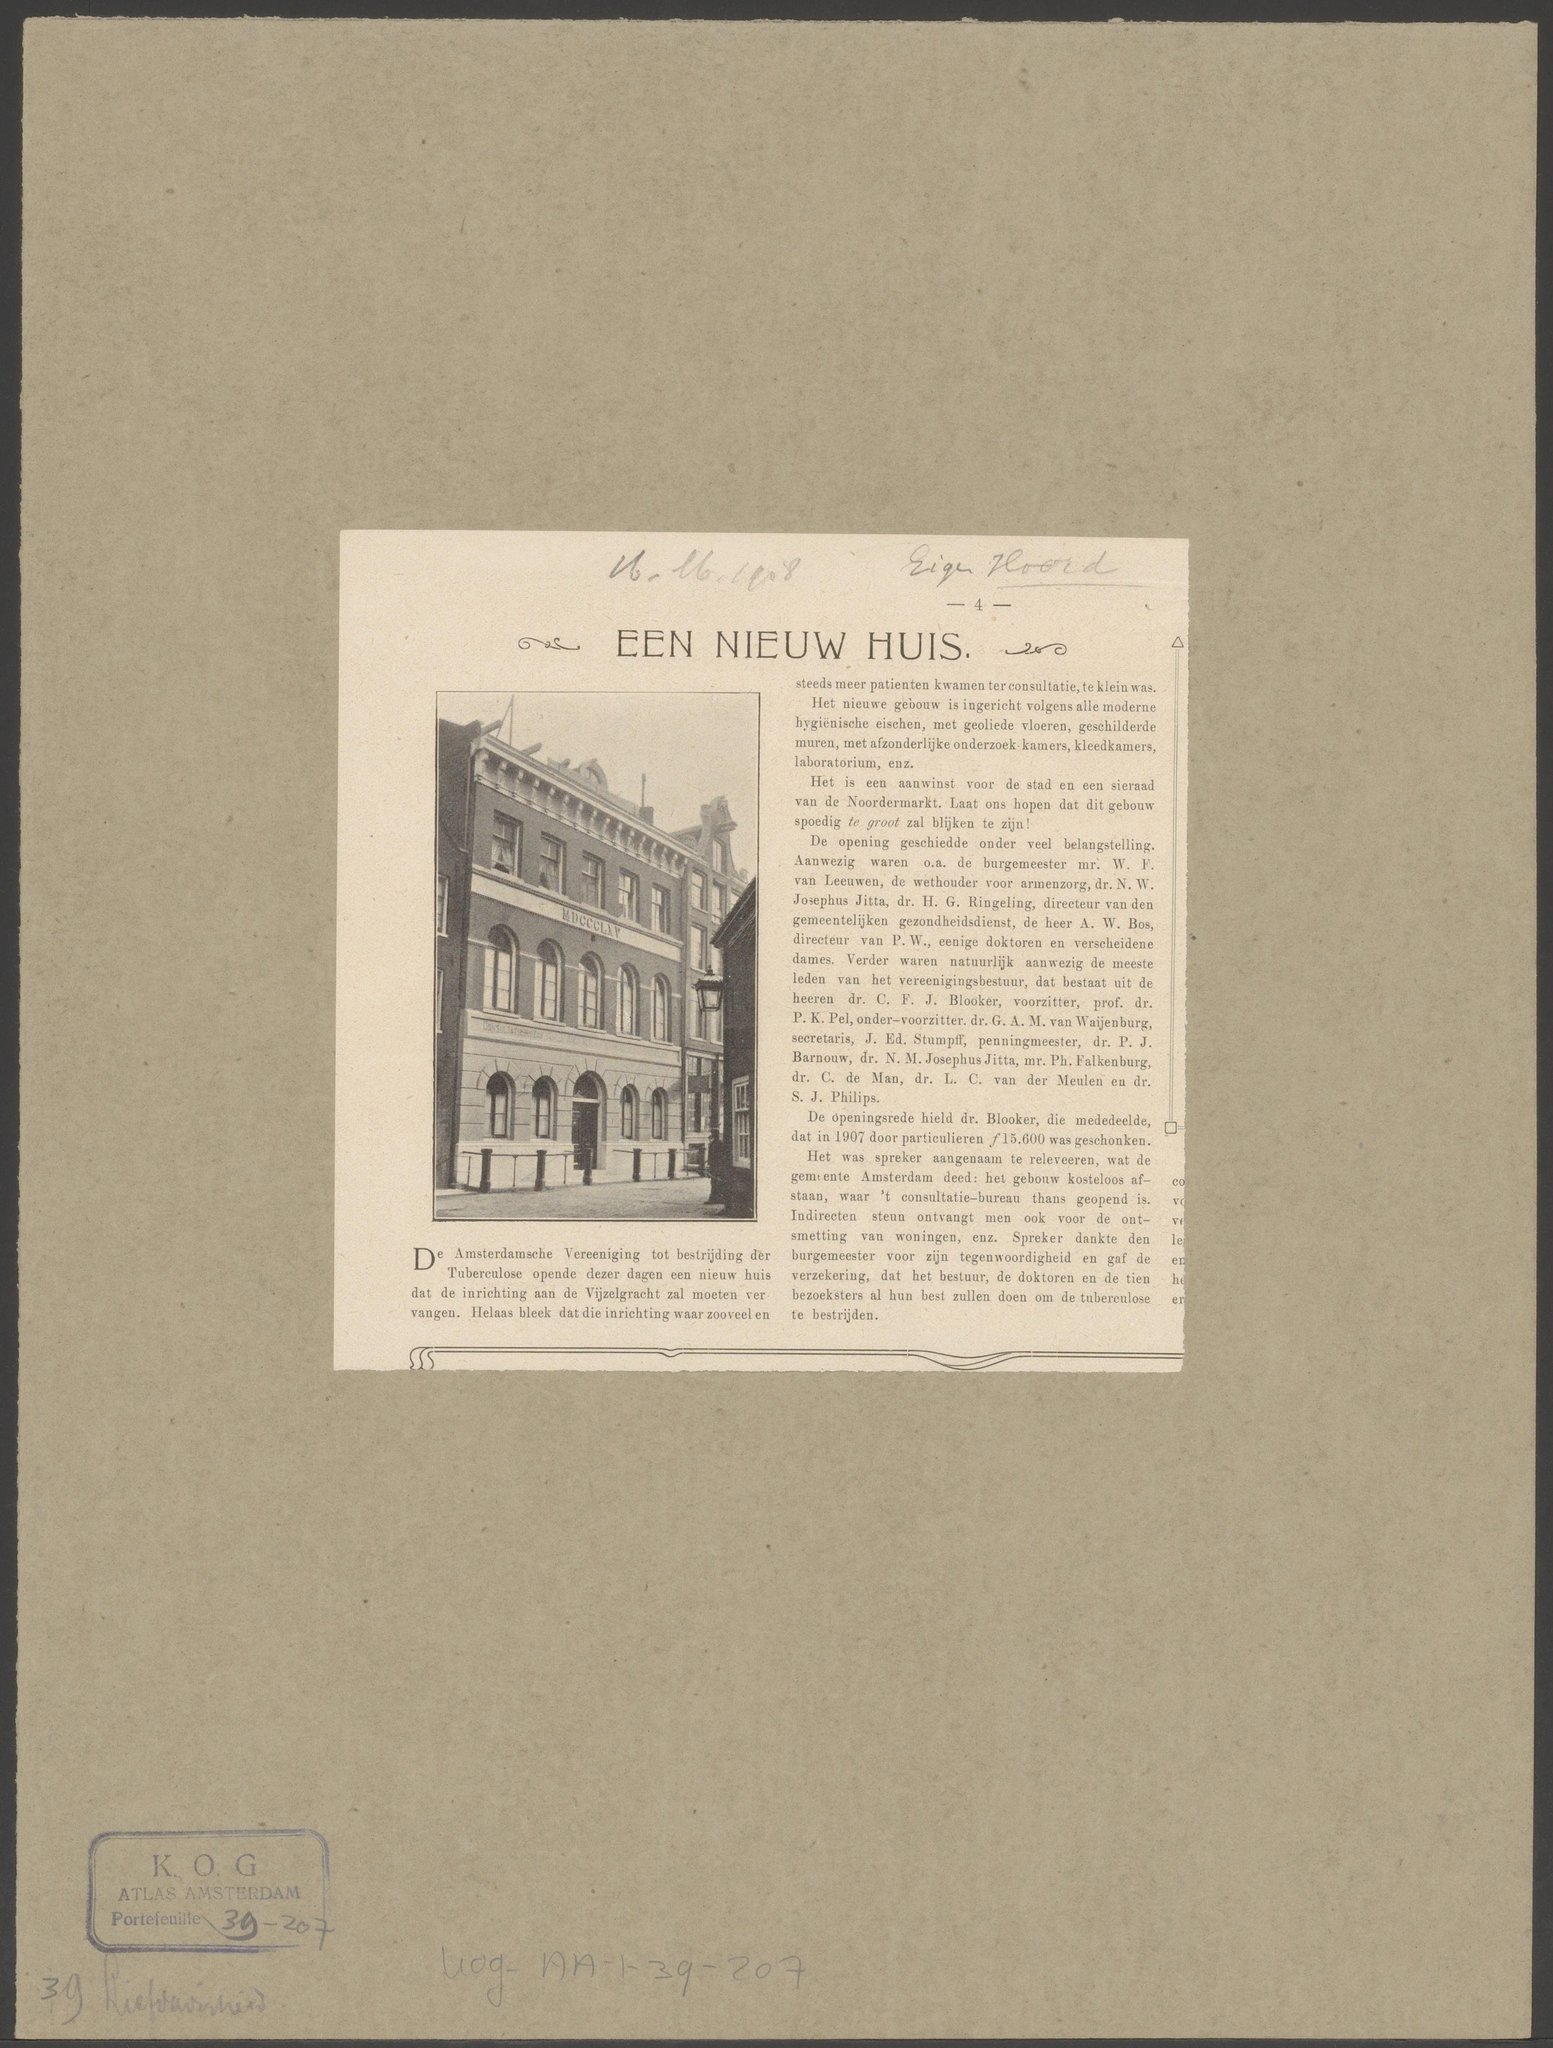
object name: photomechanical print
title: Gezicht op het kantoor en consultatiebureau van de Amsterdamsche Vereeniging tot Bestrijding der Tuberculose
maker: Anonymous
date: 1908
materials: paper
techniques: letterpress printing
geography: amsterdam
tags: institution for contagious diseases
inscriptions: collector's mark: Lugt 1641b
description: Onderwerpsrubriek binnen de Atlas Amsterdam: Armwezen en liefdadige instellingen: V. Ziekenhuizen: Ver. voor Ziekenverpleging aan de Prinsengracht.